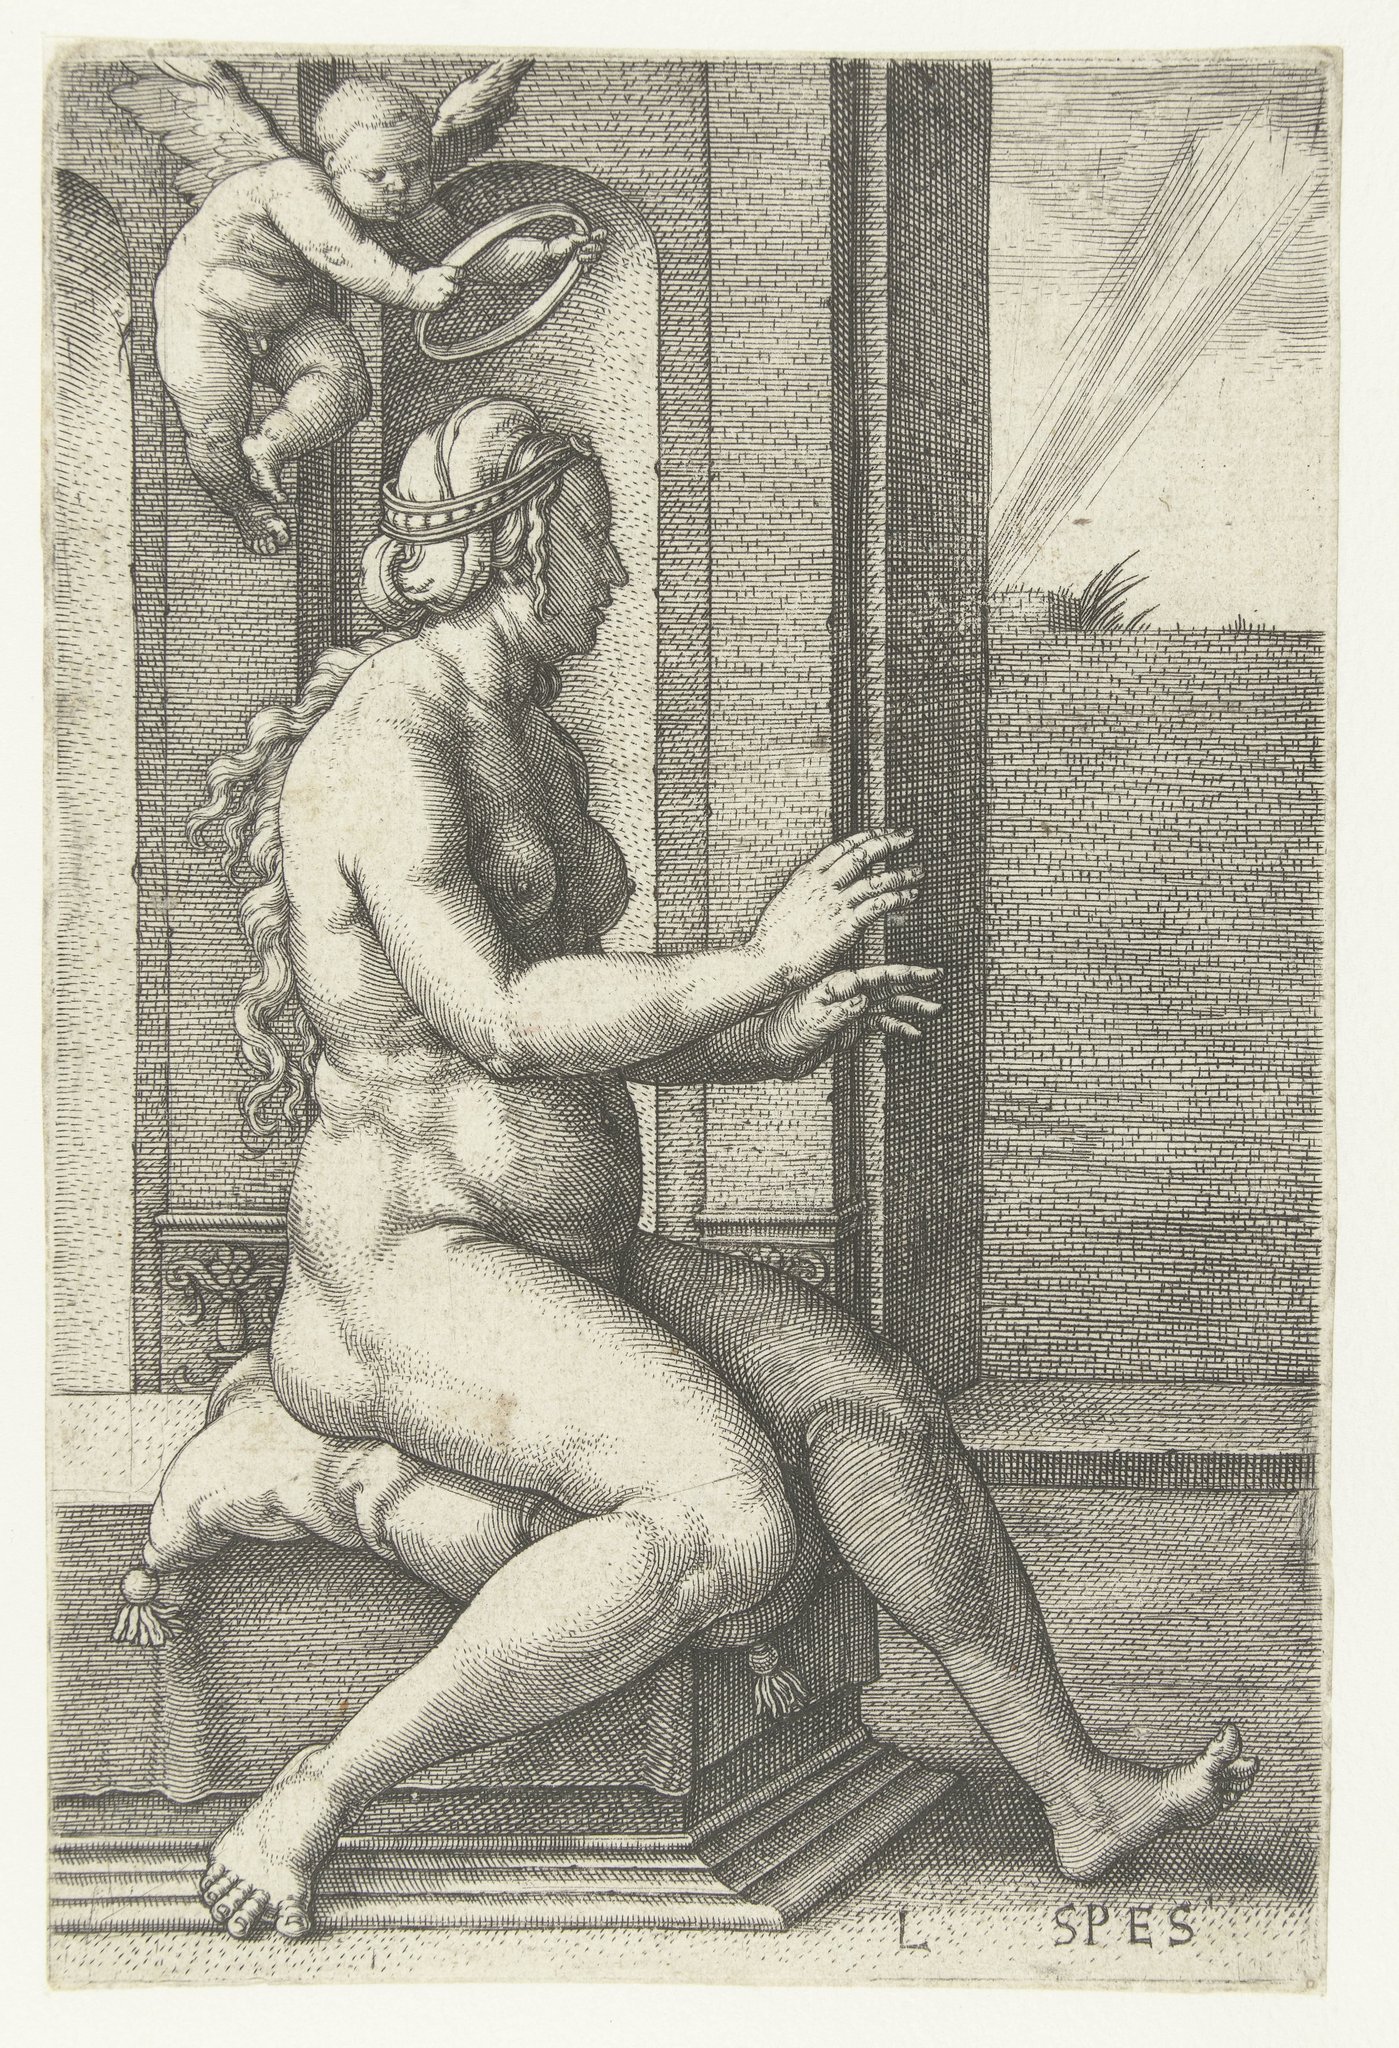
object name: print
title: Spes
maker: lucas van leyden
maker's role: draughtsman, painter, print maker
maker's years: 1494-1533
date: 1530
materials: paper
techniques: engraving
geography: low countries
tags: hope, 'spes'; 'speranza divina e certa' (ripa) ~ one of the three theological virtues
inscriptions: collector's mark: Lugt 240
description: Personificatie van de deugd Hoop: naakte vrouw zittend, putto houdt cirkelvormige band boven haar hoofd, lichtstralen vallen kamer binnen.